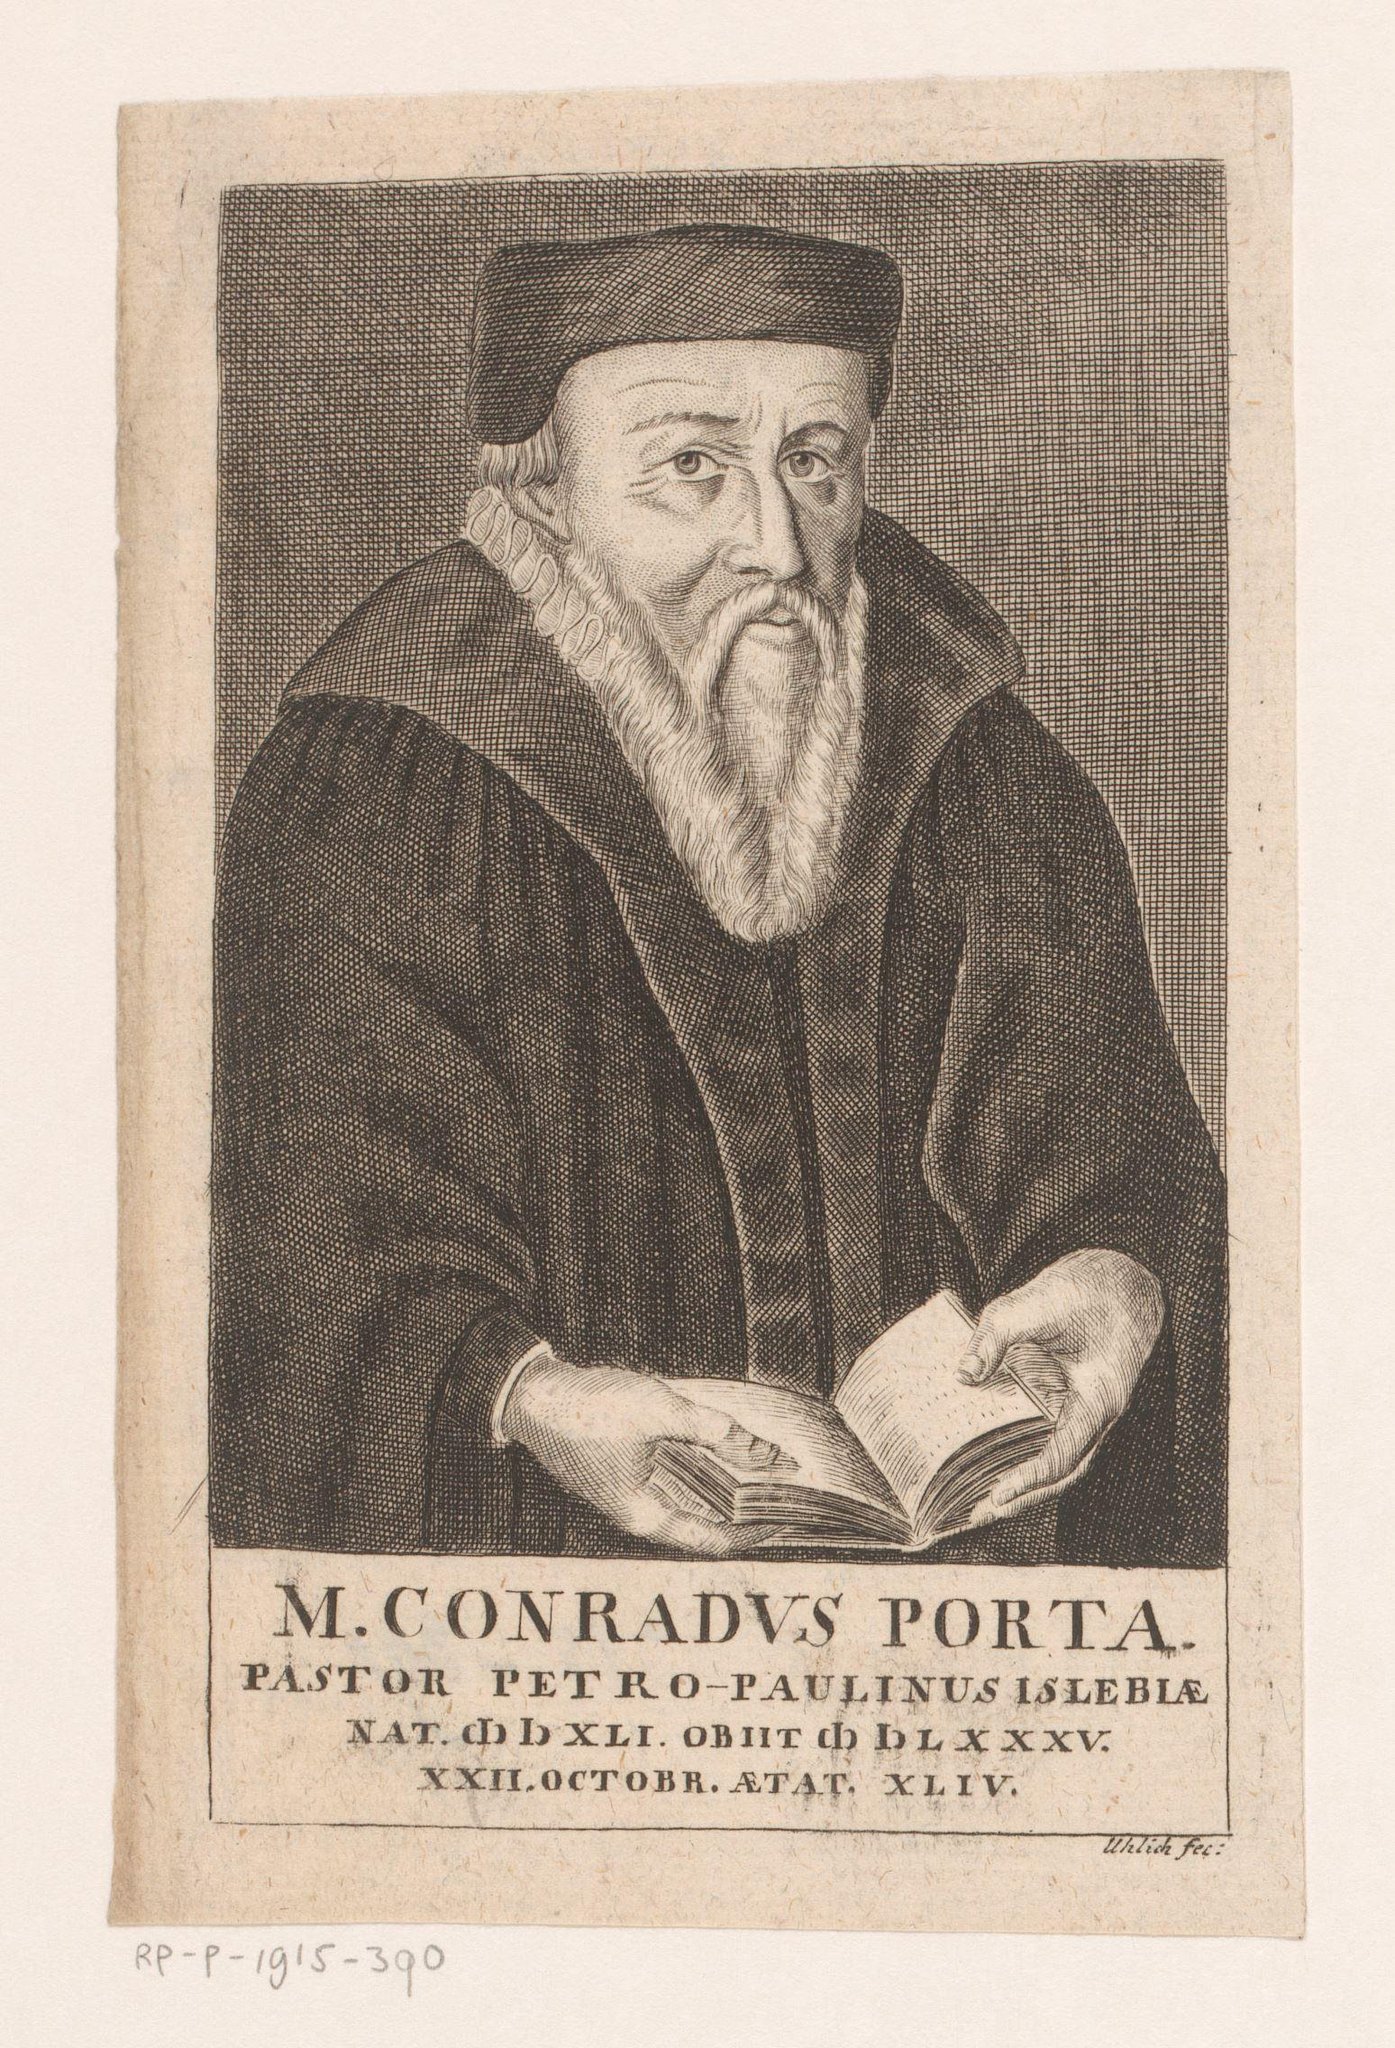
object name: print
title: Portret van Conrad Porta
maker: gabriel uhlich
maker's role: print maker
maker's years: 1682-1741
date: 1725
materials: paper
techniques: engraving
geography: leipzig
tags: historical persons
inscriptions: collector's mark: Lugt 2228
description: Prent gebruikt voor de publicatie: Fortgesetzte Sammlung von Alten und Neuen Theologischen Sachen. Leipzig: Johann Friedrich Brauns Erben, 1725.